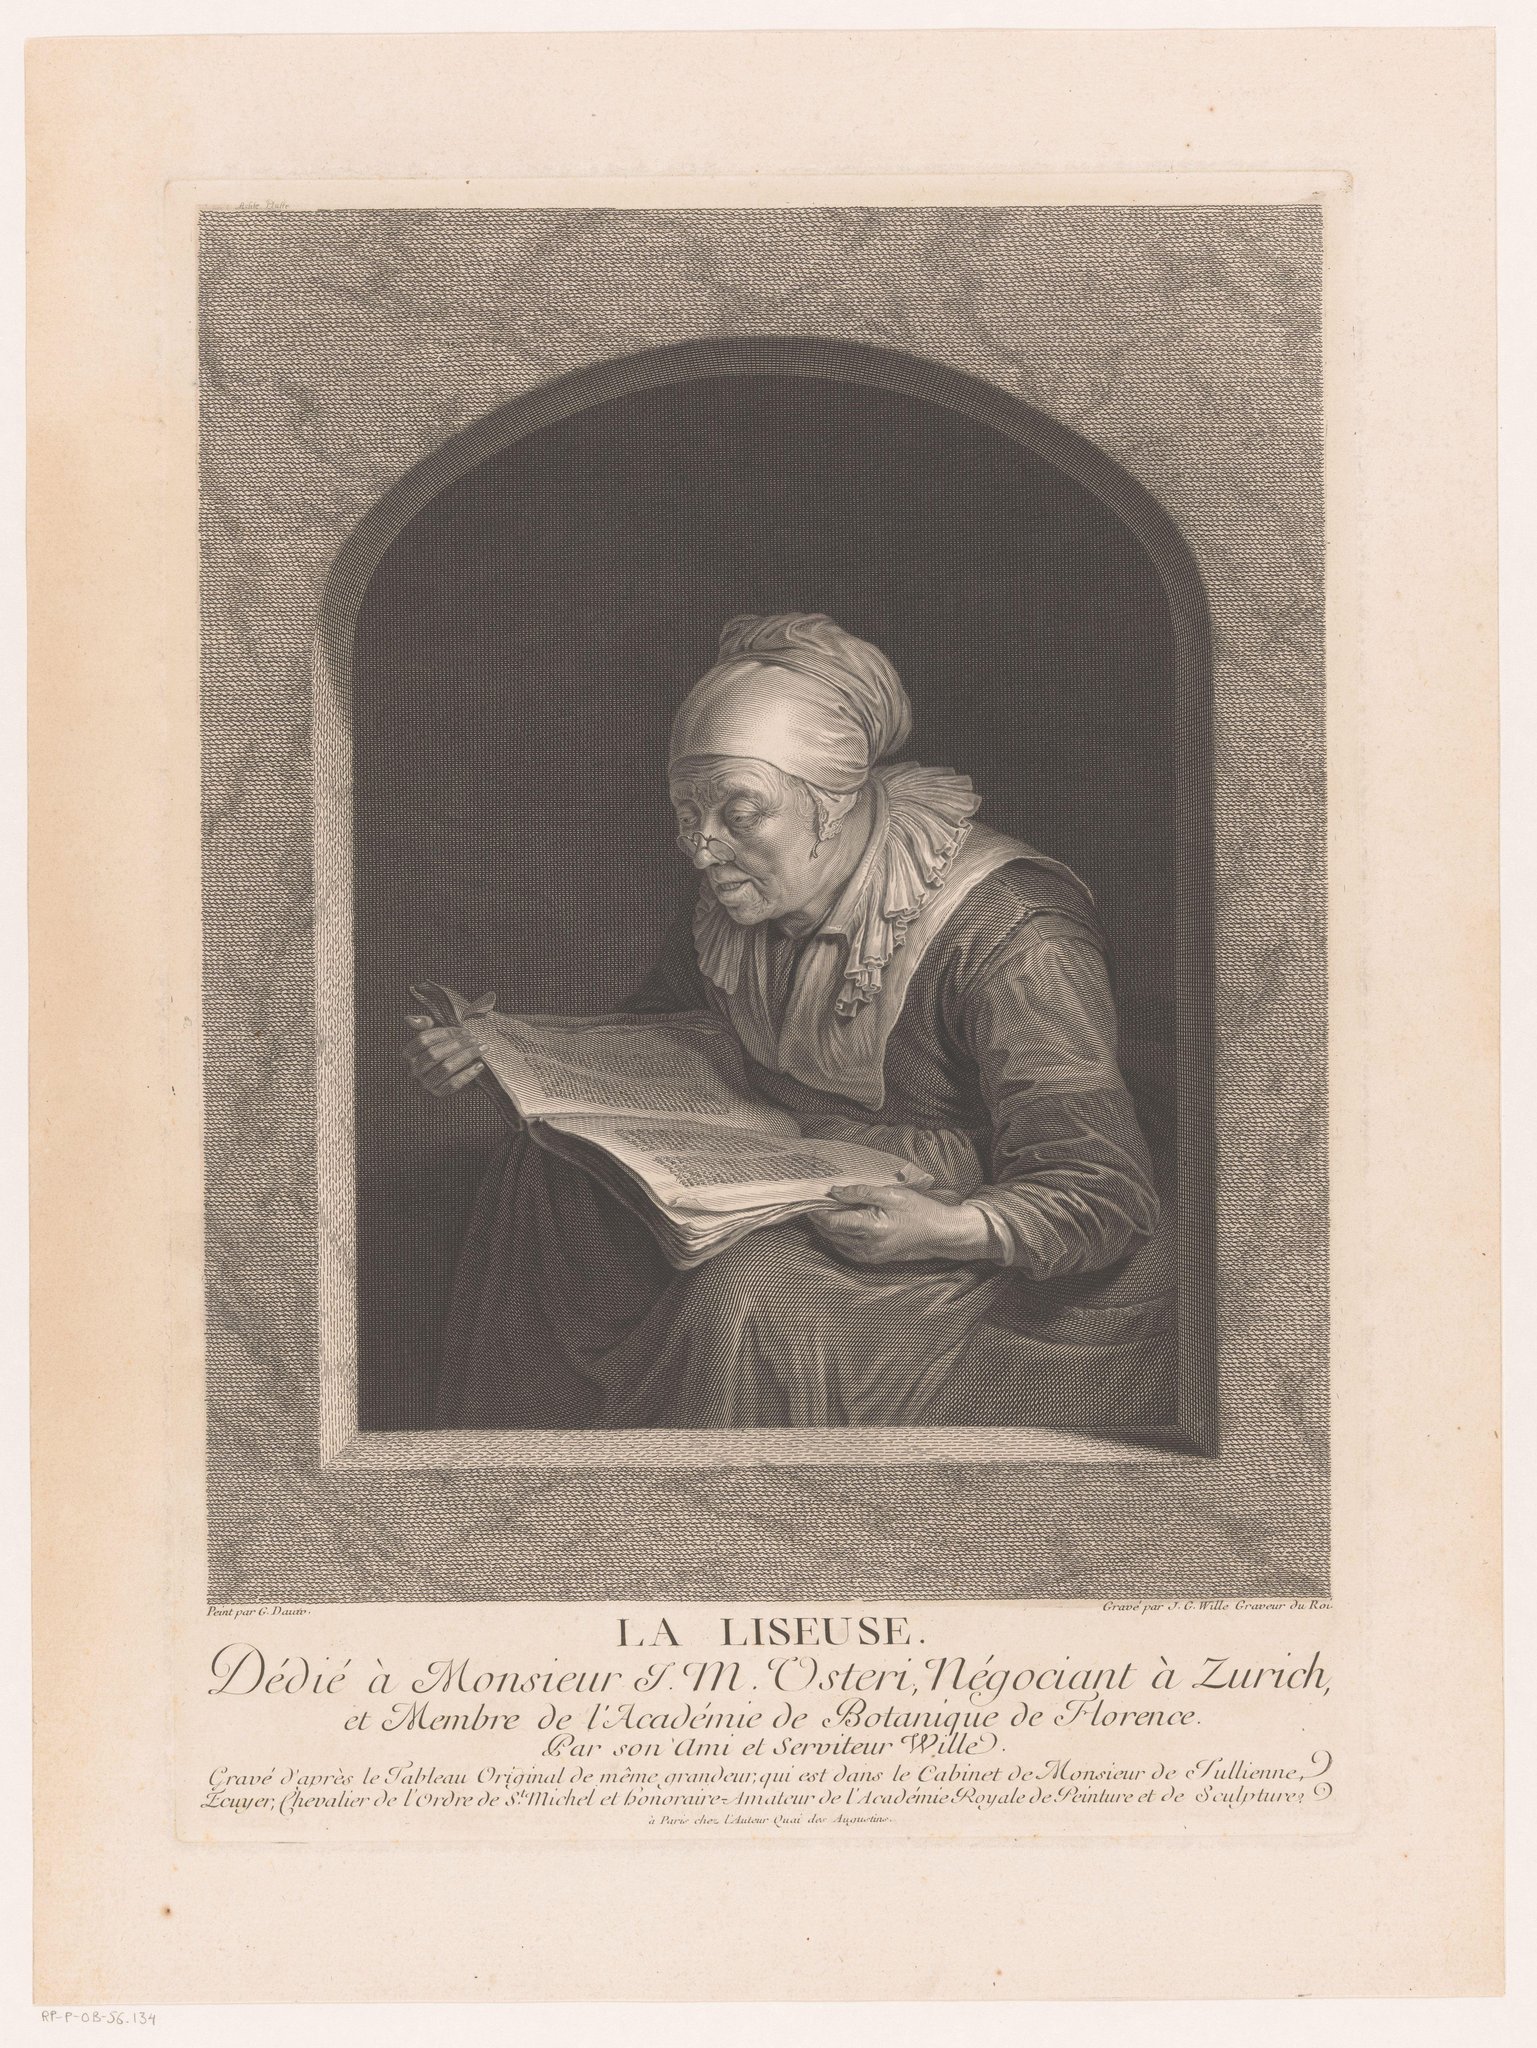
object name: print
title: La liseuse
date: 1761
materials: paper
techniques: engraving, etching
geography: paris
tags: eyeglasses, spectacles, reading, old woman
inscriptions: collector's mark: Lugt 240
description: Deze prent maakt deel uit van een serie van onbekende omvang naar Nederlandse en Duitse schilderijen. Op sommige prenten staat linksboven aangegeven welk nummer in de serie het betreft.